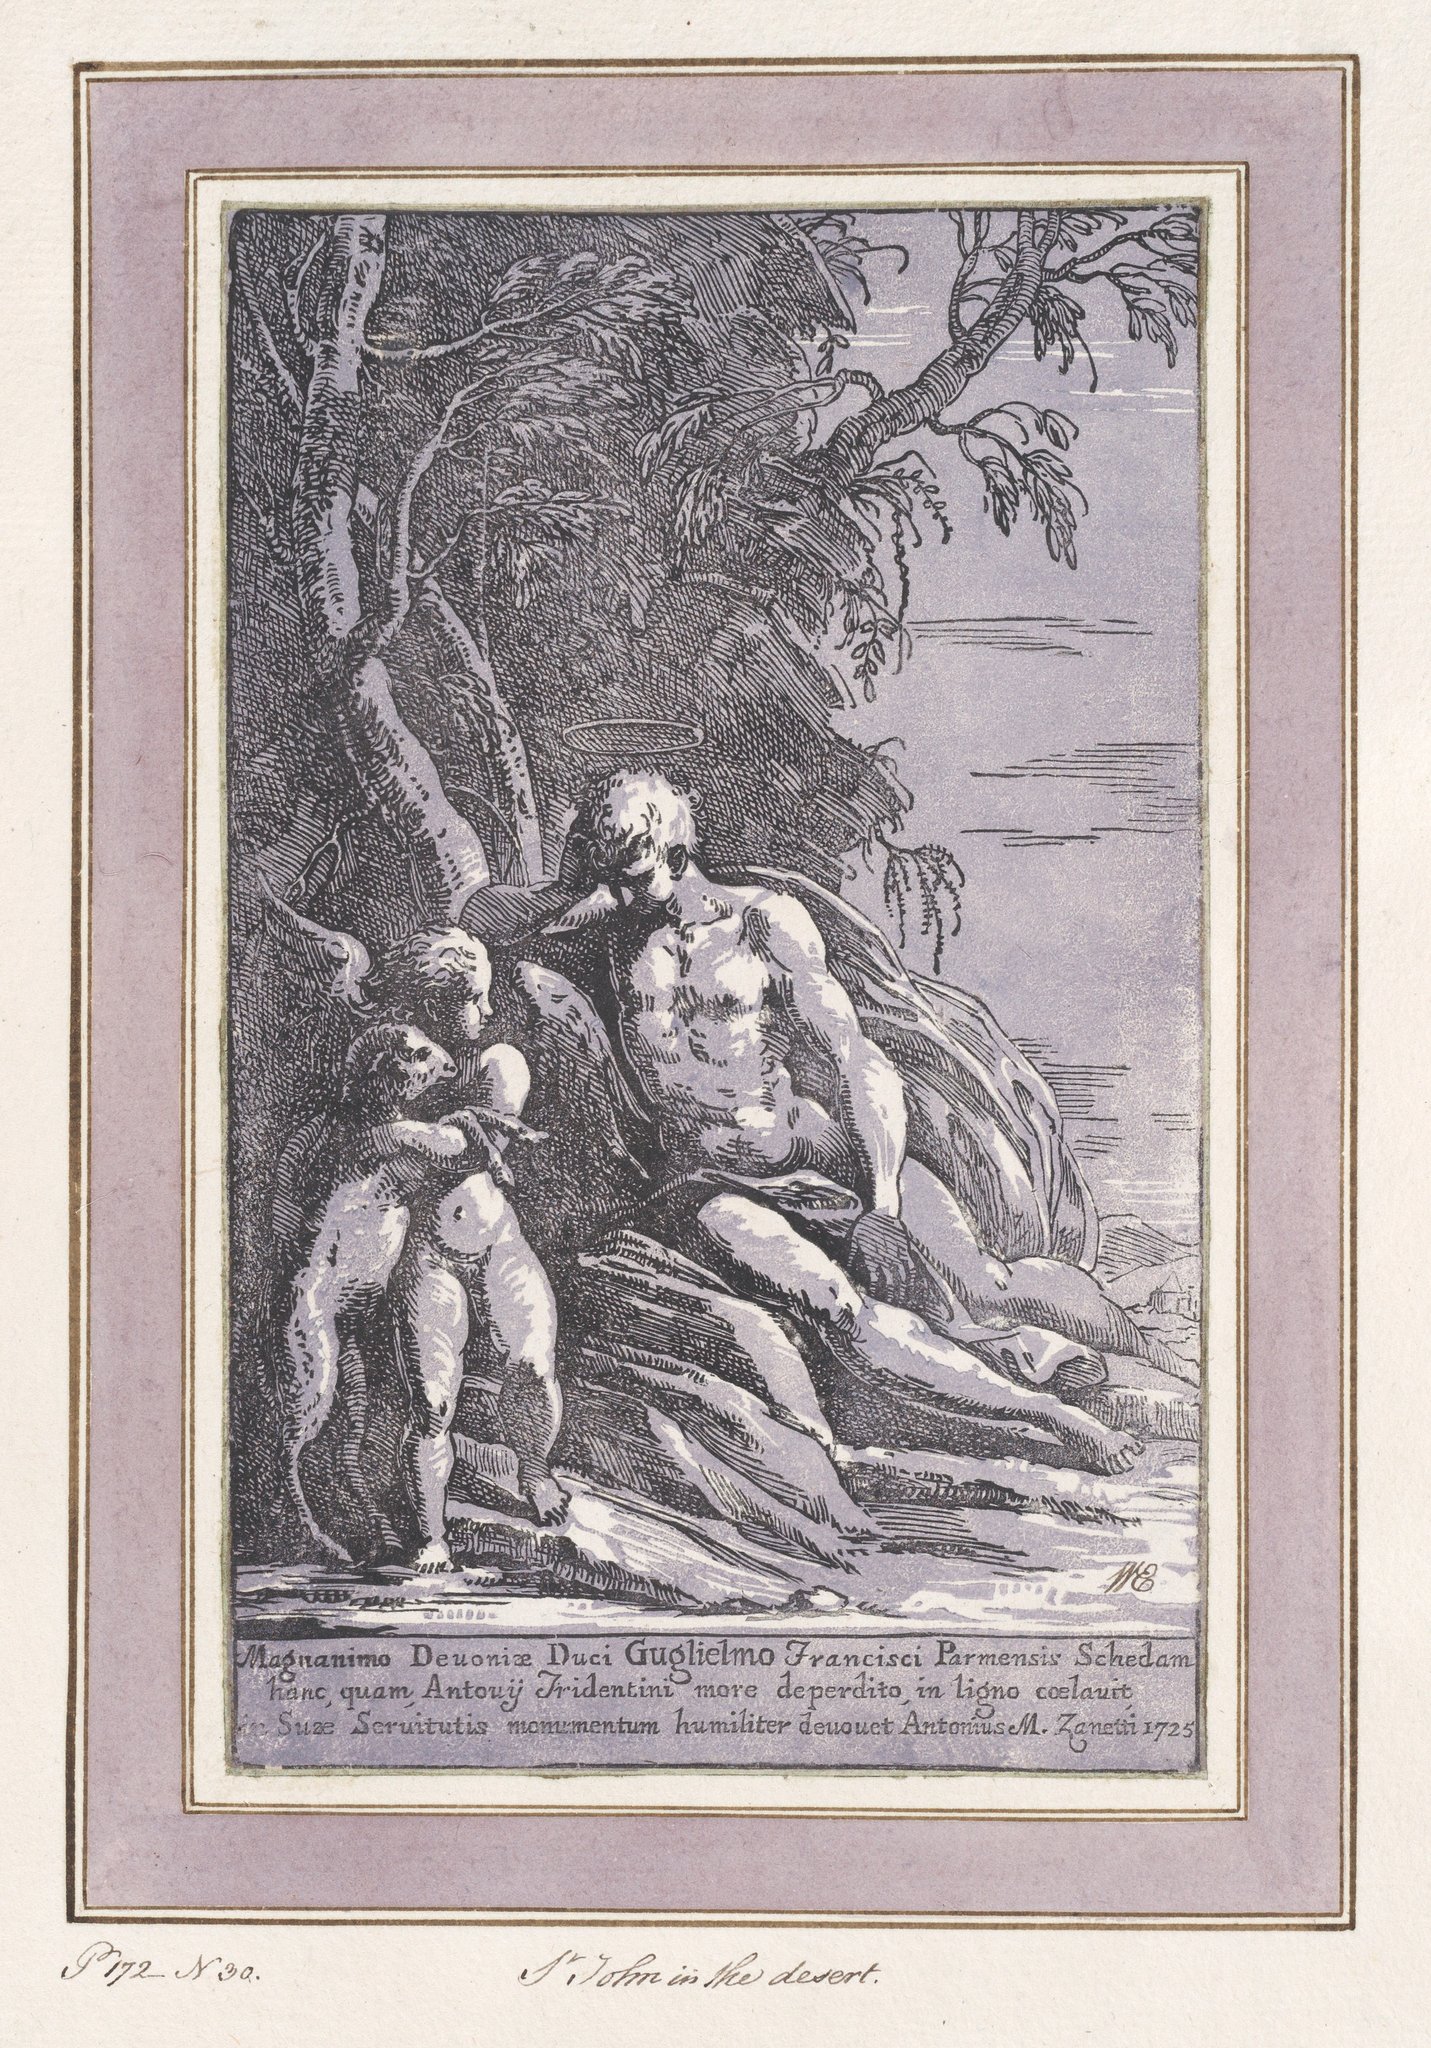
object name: print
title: Saint John in the Desert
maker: conte anton maria zanetti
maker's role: artist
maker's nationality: italian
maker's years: 1680-1767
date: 1725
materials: gold, ink, watercolor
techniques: woodcut